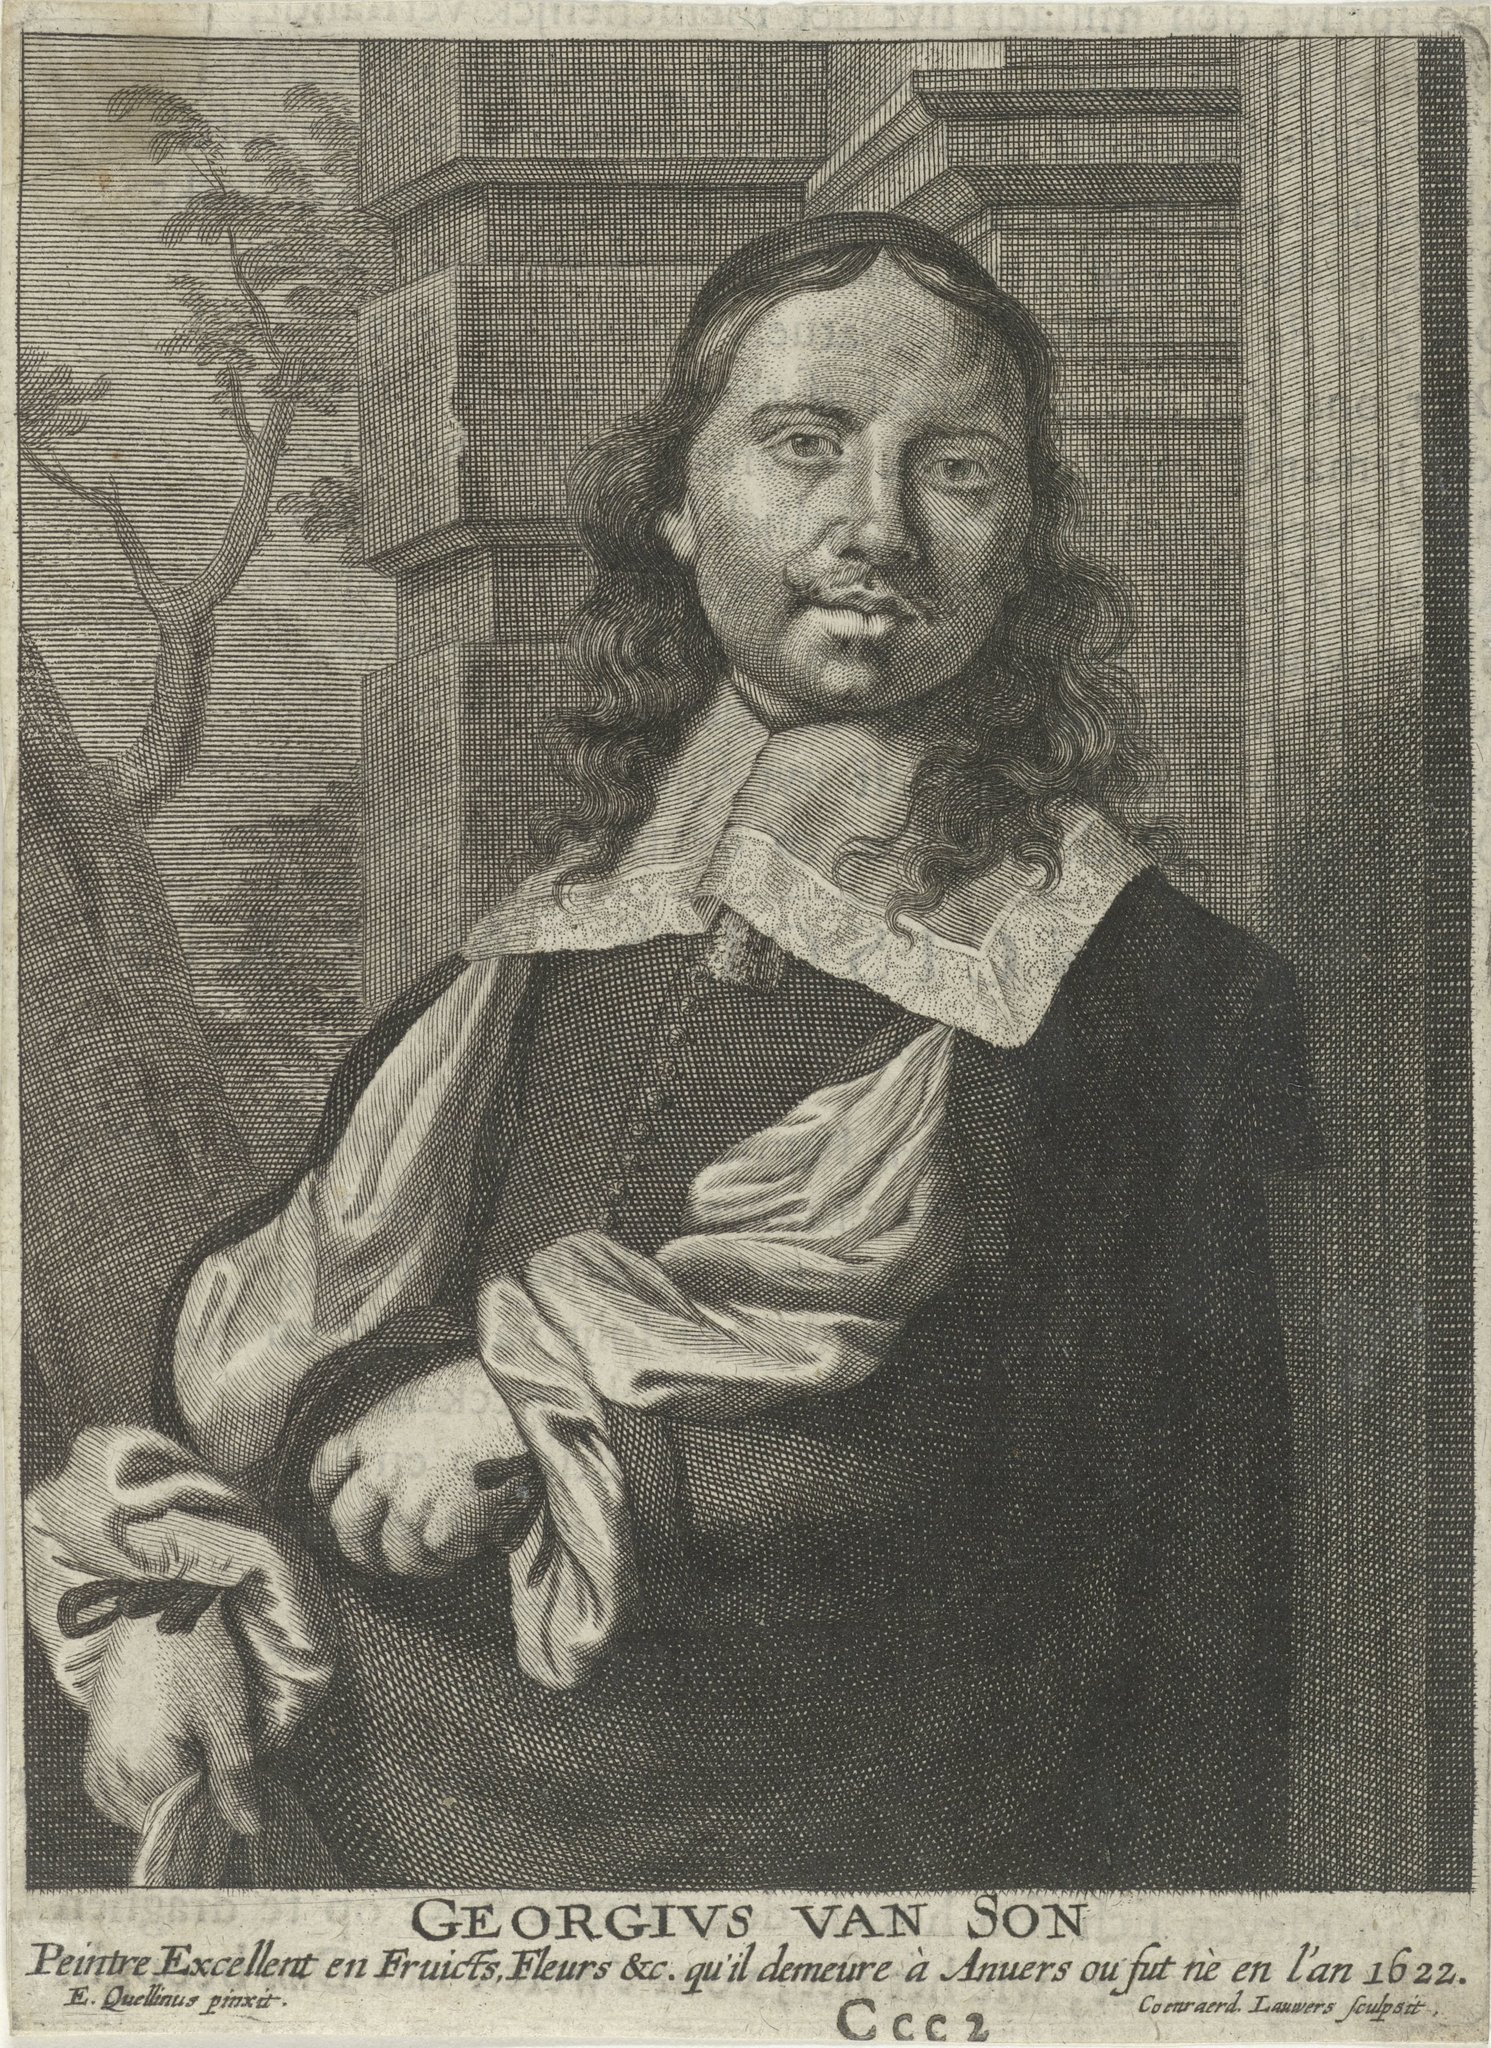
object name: book illustration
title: Portret van Joris van Son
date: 1662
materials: paper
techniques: engraving, letterpress printing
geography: antwerp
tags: painter, joris van son, historical persons, portrait, self-portrait of painter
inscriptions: collector's mark: Lugt 2228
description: Prent uit: Bie, Cornelis De. Het gulden Cabinet vande edel vry schilder const, inhoudende den lof vande vermarste schilders, architecte, beldthowers ende plaetsnyders van dese eeuw. Antwerpen: Joannes Meyssens, 1662 [1661 foutief op titelpagina], p. 403. Huidige staat (ongenummerd) mogelijk eerder gebruikt in: Meyssens, Joannes. Image de divers hommes desprit sublime qui par leur art et science deburovent vivre eternellement et des quels la louange et renommée faict estonner le monde. 2 dln. Antwerpen: Joannes Meyssens, 1649. Tweede bekende staat (genummerd 91) gebruikt in: Resta, Sebastiano. The true effigies of the most eminent painters and other famous artists that have flourished in Europe. Londen, 1694. Derde bekende staat (genummerd 70) gebruikt in: The Portraits of the Most Eminent Painters, and other Famous Artists (...). Londen: Olive Payne, 1739.